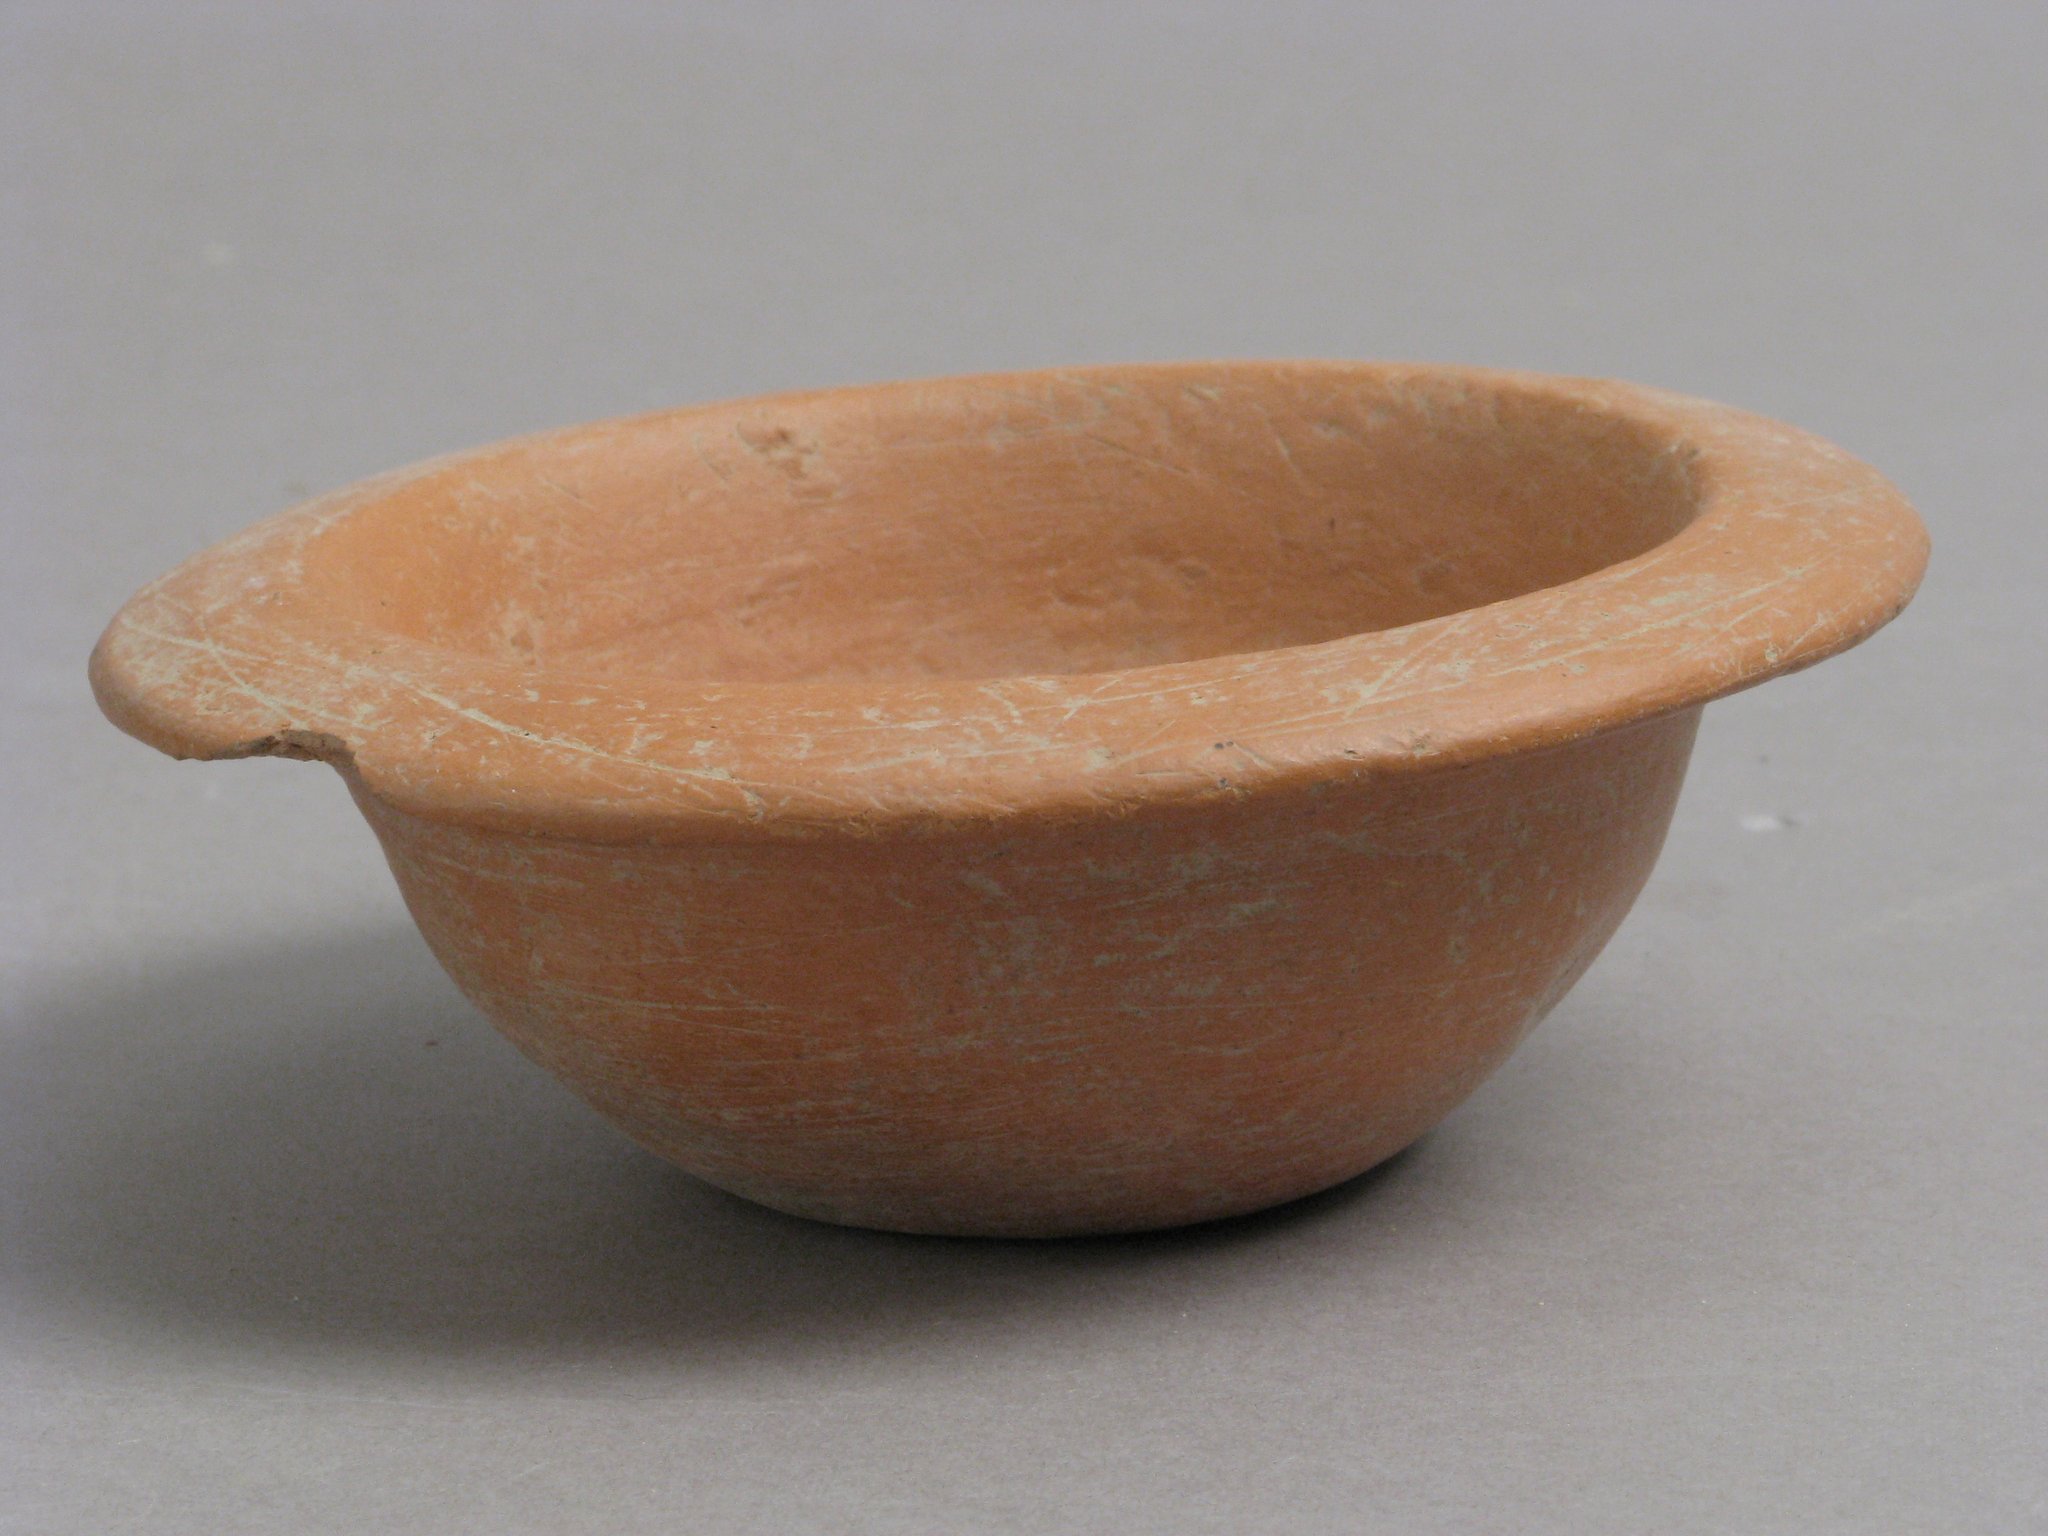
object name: bowl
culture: coptic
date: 301-700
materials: earthenware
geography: egypt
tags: bowls